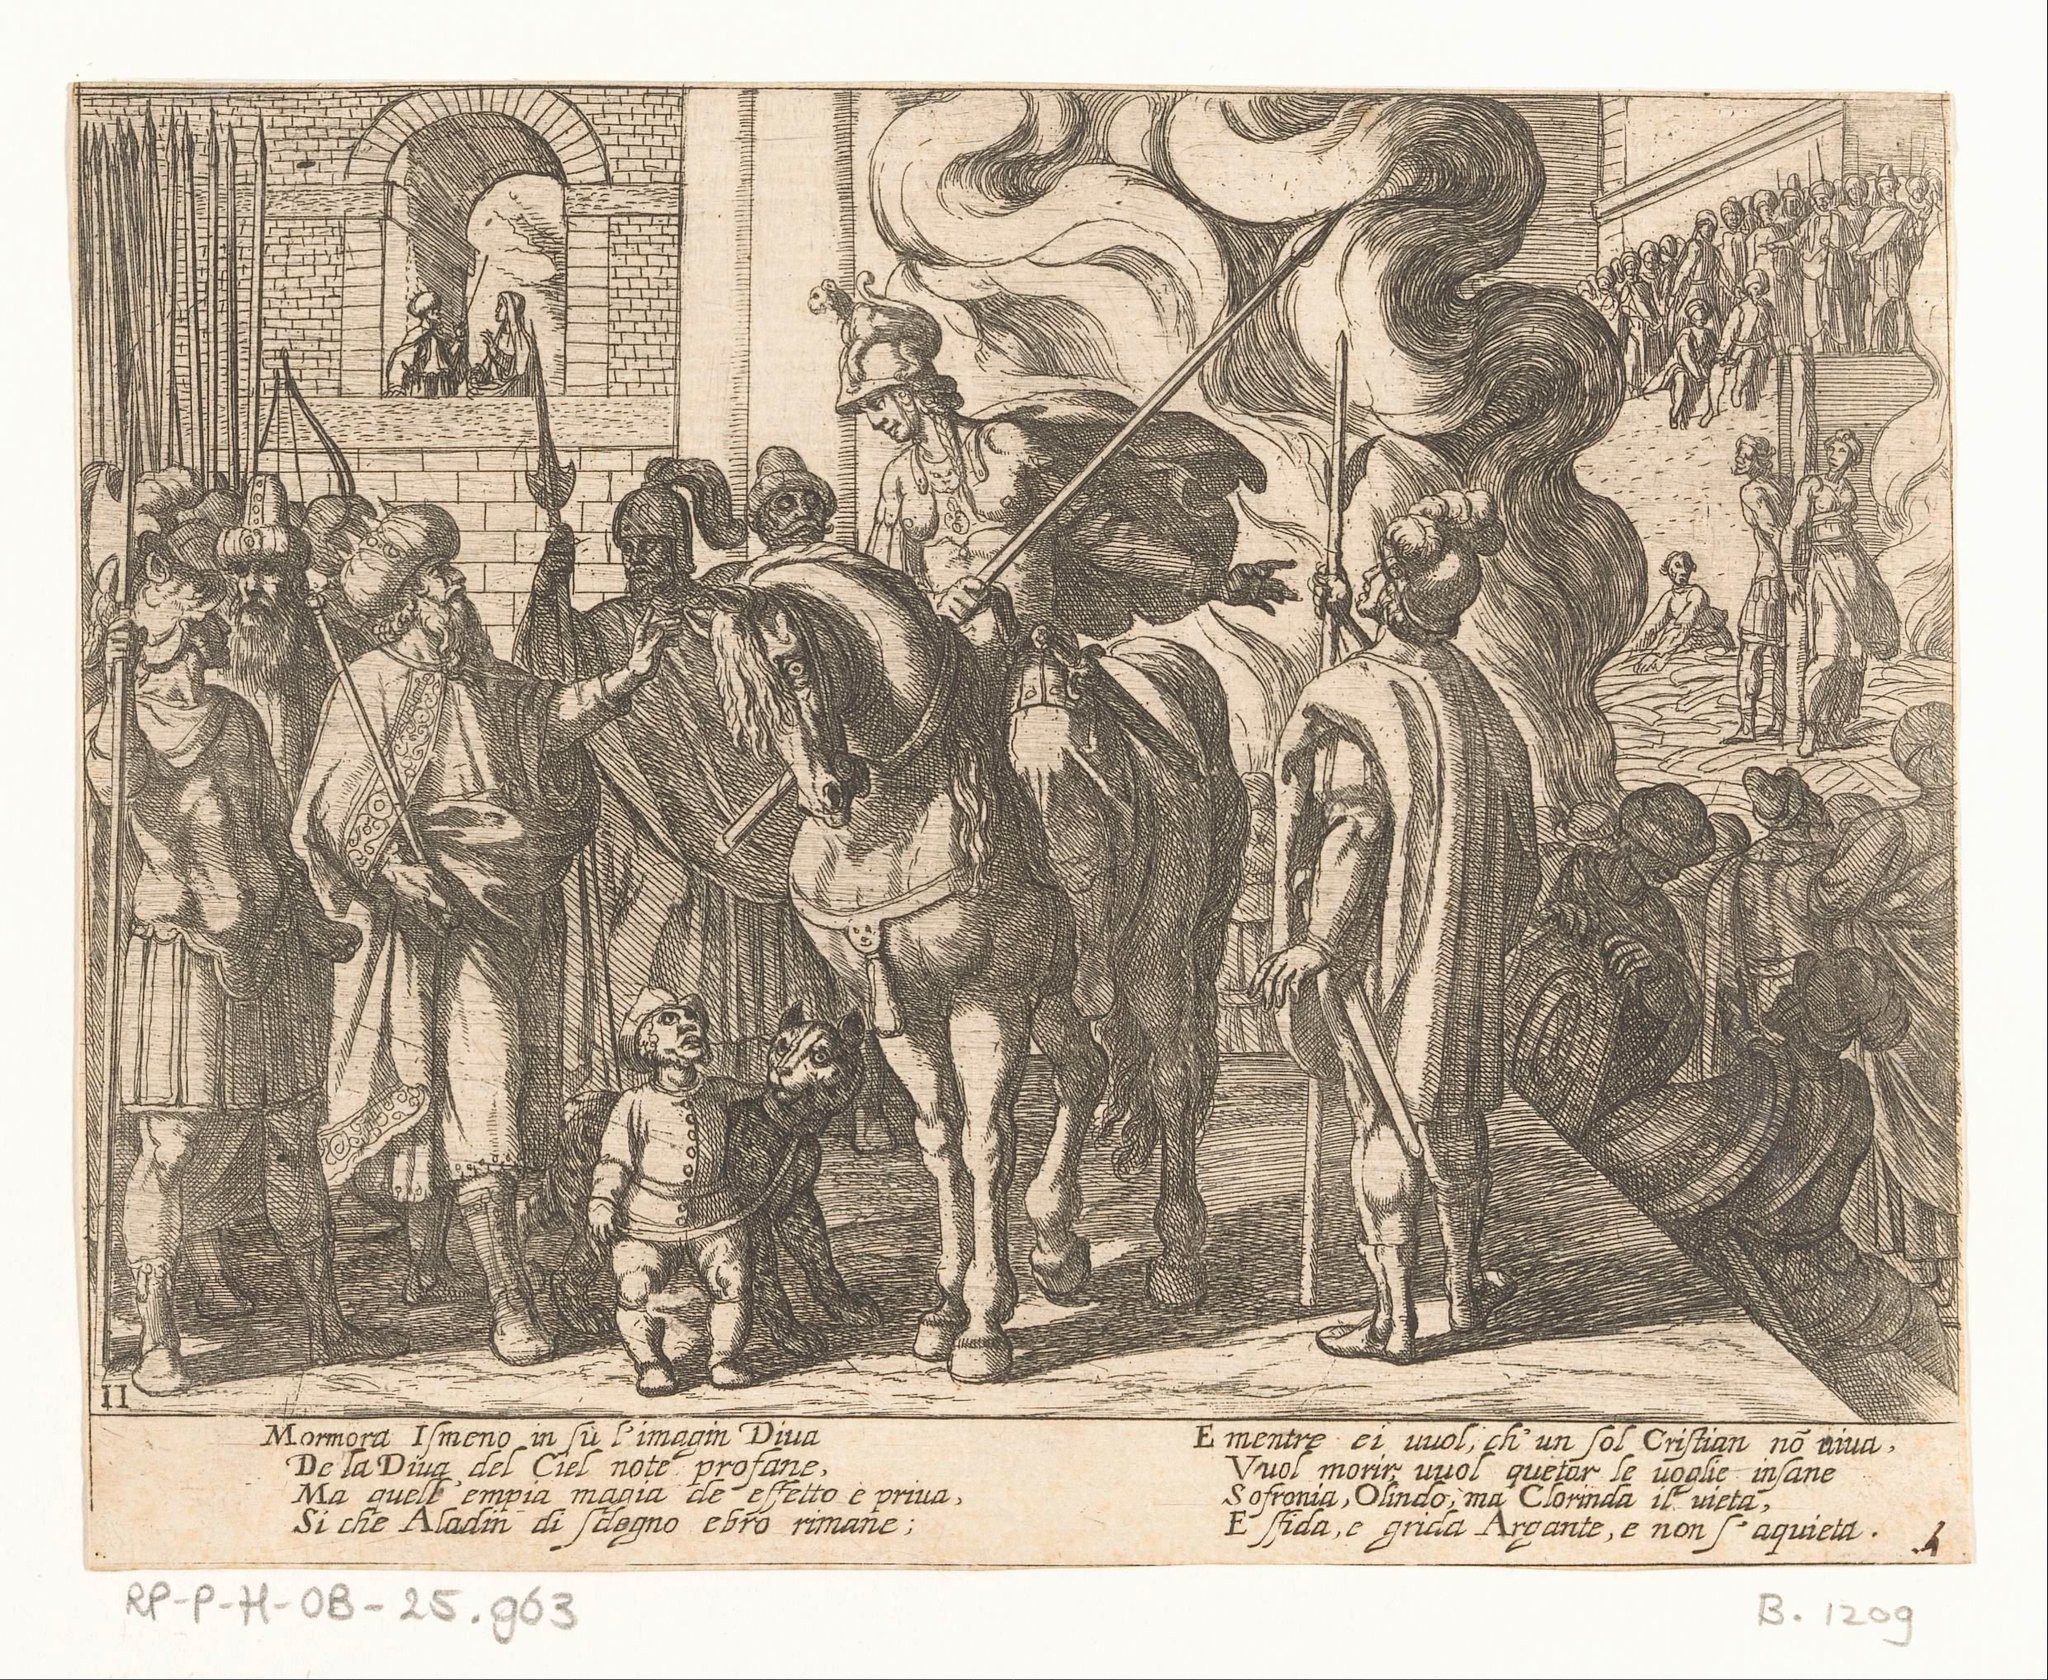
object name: print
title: Gerusalemme Liberata (deel 2)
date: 1565-1630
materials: paper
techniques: etching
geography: italy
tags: violent death by burning at the stake; pyre, militant proselytizing: religious war, crusade, etc., (scenes from) specific works of literature: tasso, gerusalemme liberata, knight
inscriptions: number: ‘4’, collector's mark: Lugt 11, collector's mark: ‘Hinloopen’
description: Deze prent maakt deel uit van een reeks van twintig prenten (+ opdracht) met voorstellingen van scènes uit Tasso's 'Jeruzalem verlost', een episch gedicht geschreven door de Italiaanse dichter Torquato Tasso en voor het eerst gepubliceerd in 1581. Het verhaal vertelt grotendeels in fictie over de Eerste Kruistocht waarin de christenen, geleid door Godfried van Bouillon, de strijd aangaan met de moslims om het Beleg van Jeruzalem.